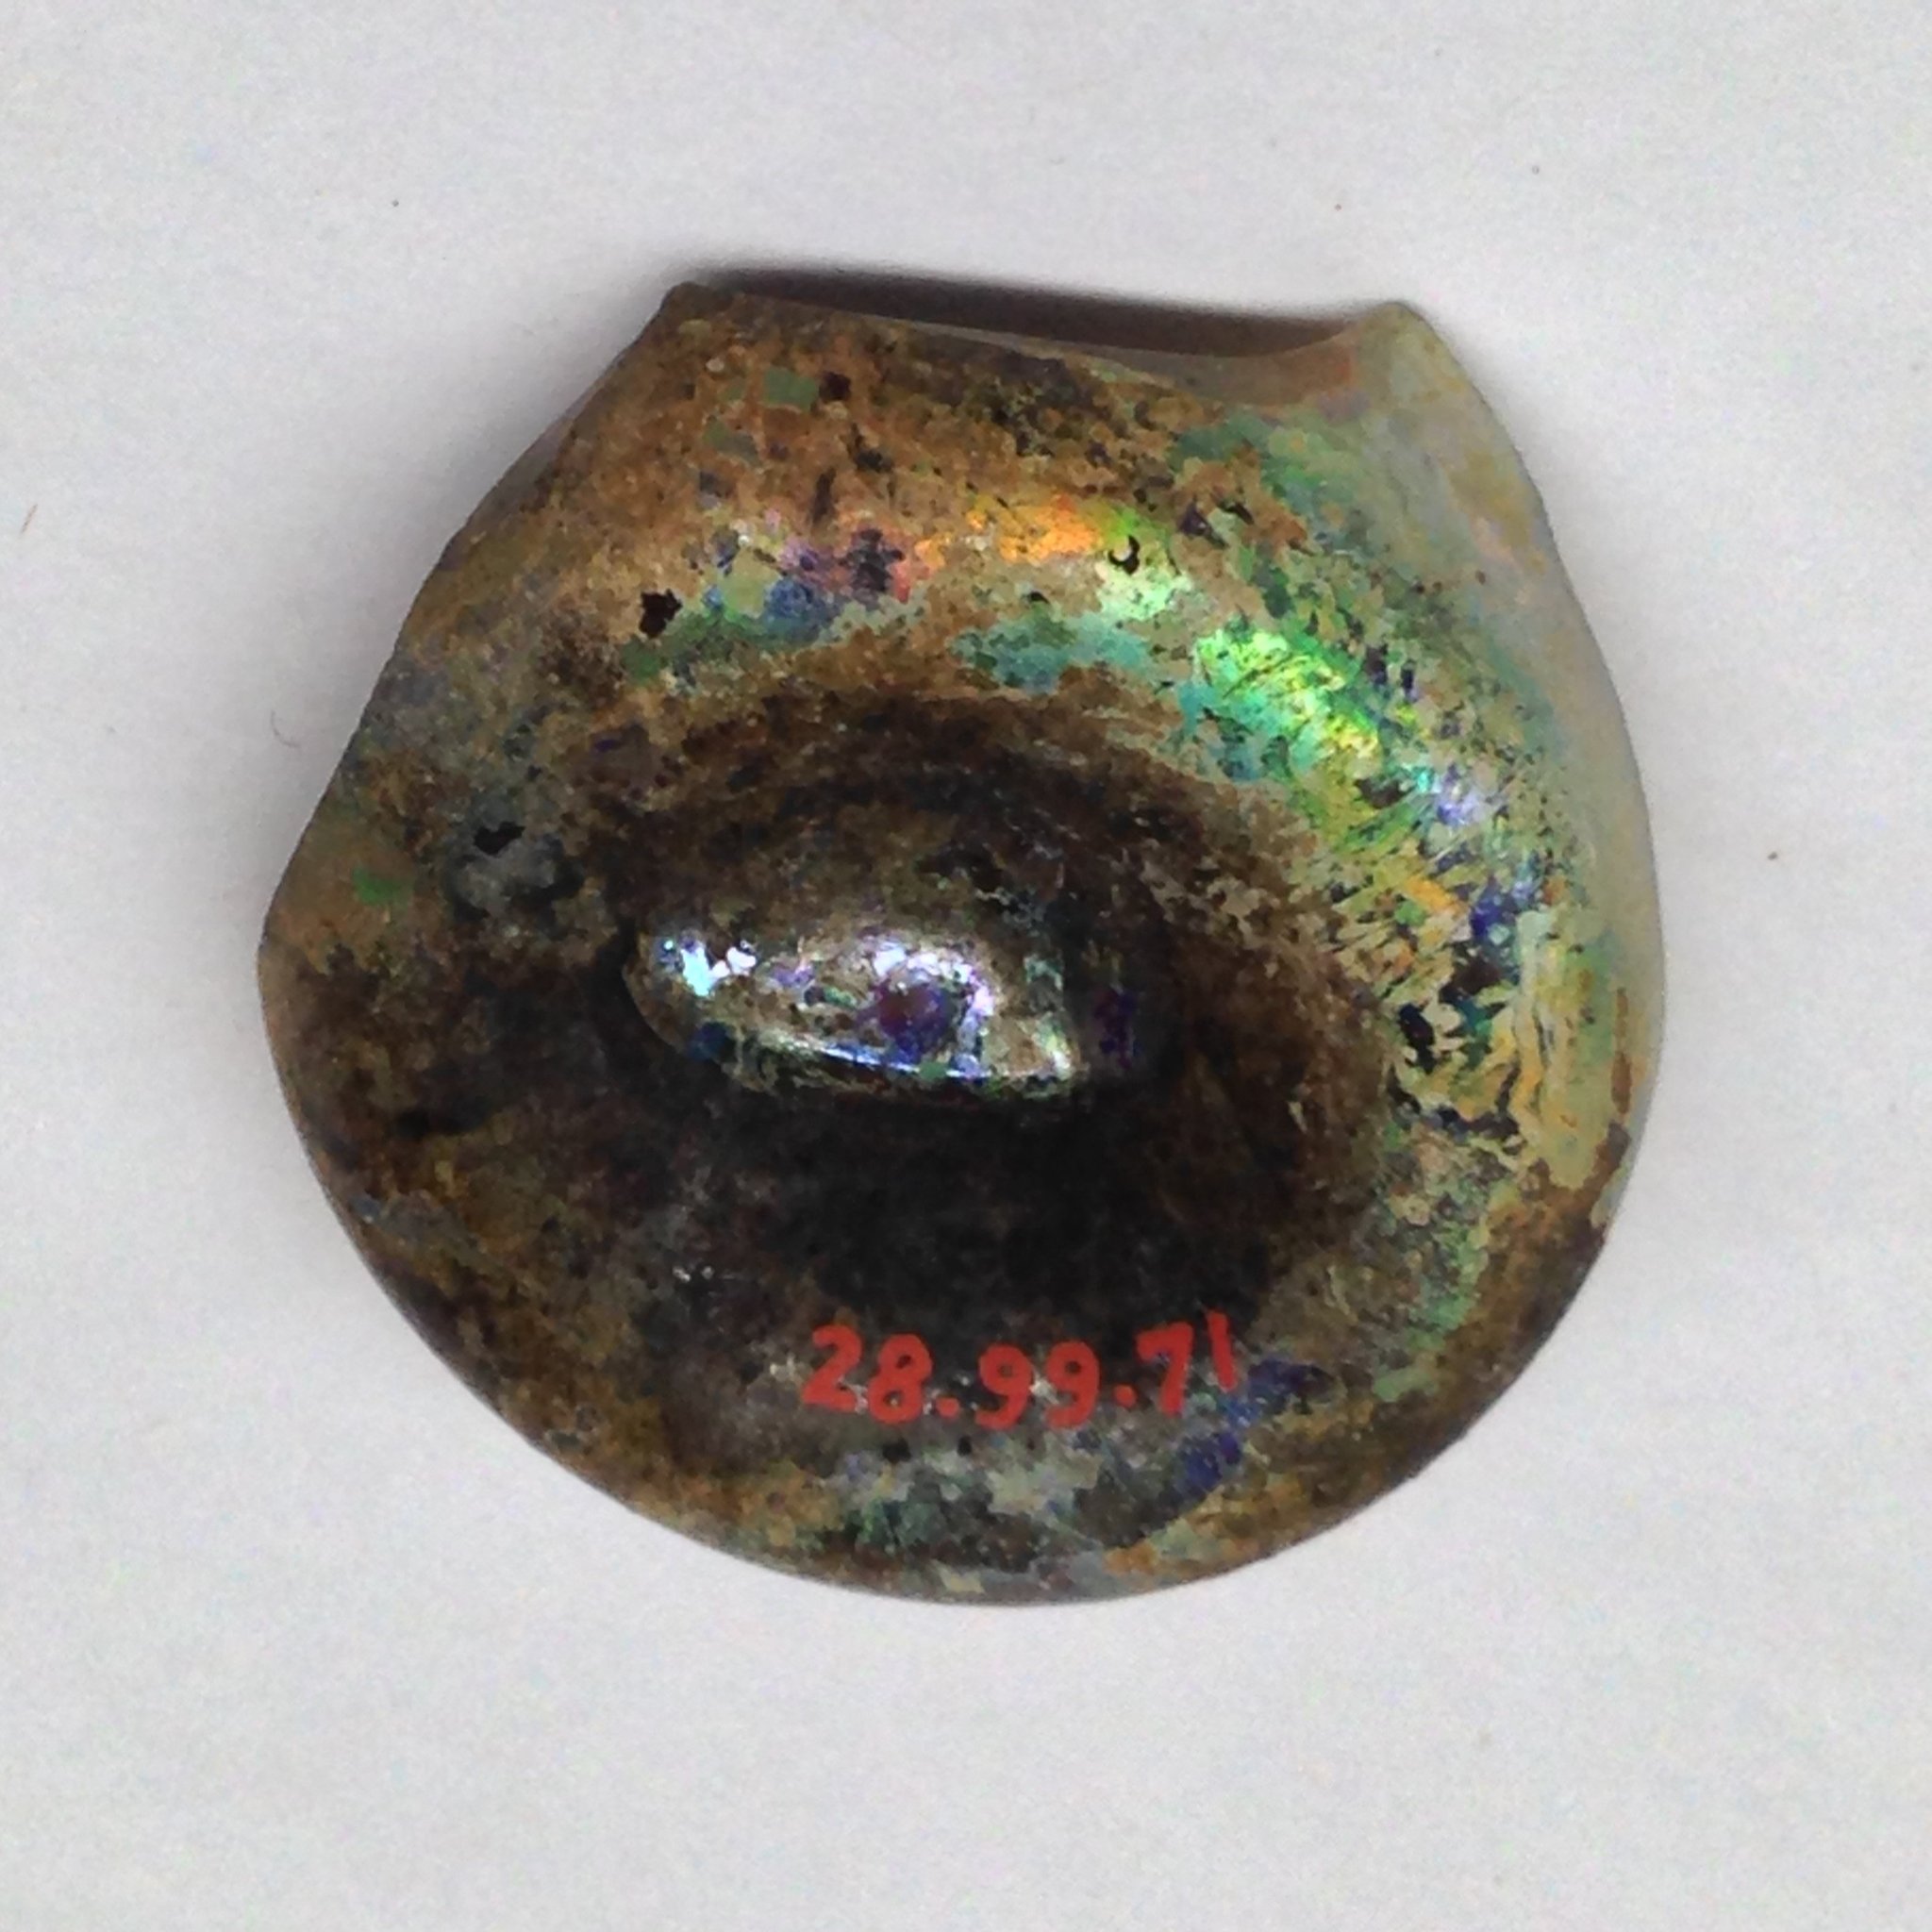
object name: fragment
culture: european or middle eastern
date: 1150-1250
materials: ceramic, glass